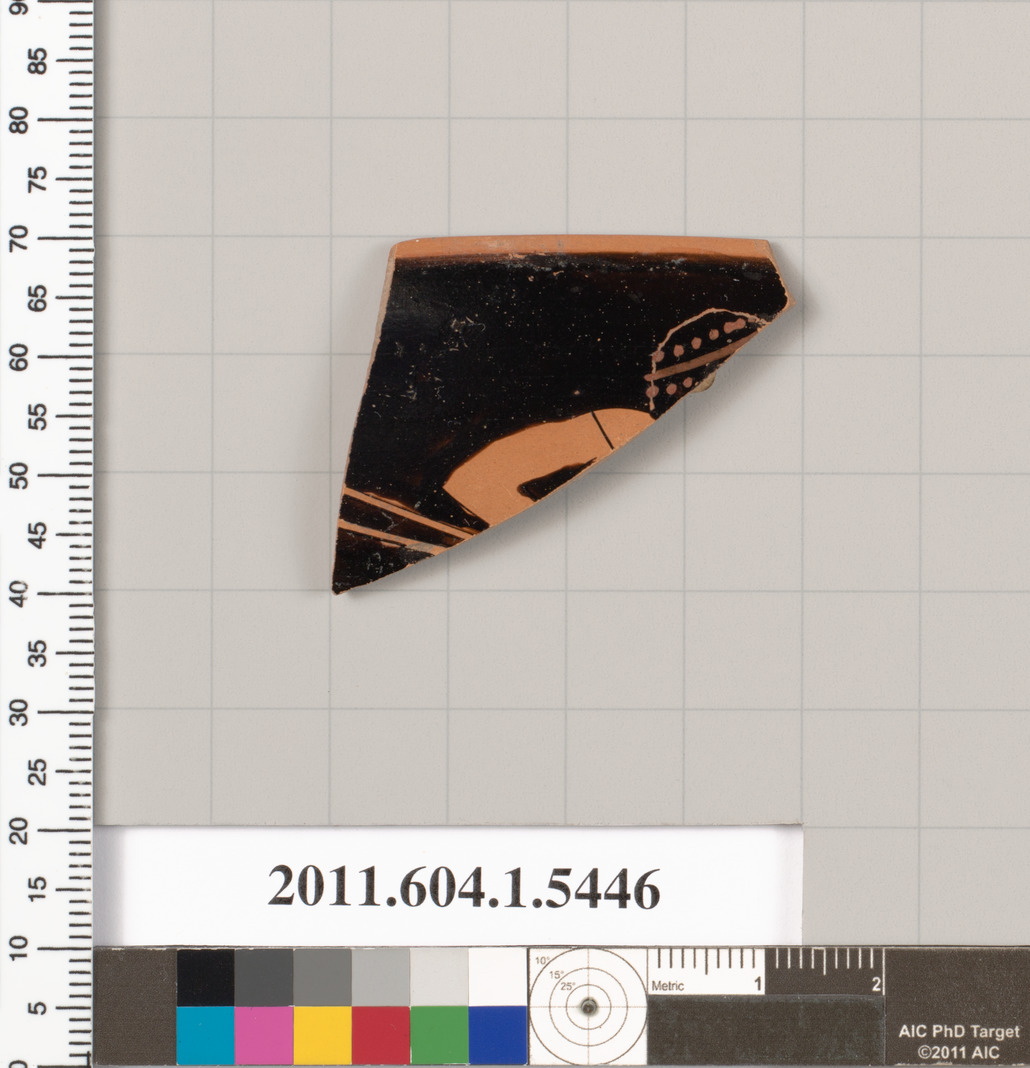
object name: kylix fragment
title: Terracotta rim fragment of a kylix (drinking cup)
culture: greek, attic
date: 500-480 BCE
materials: terracotta